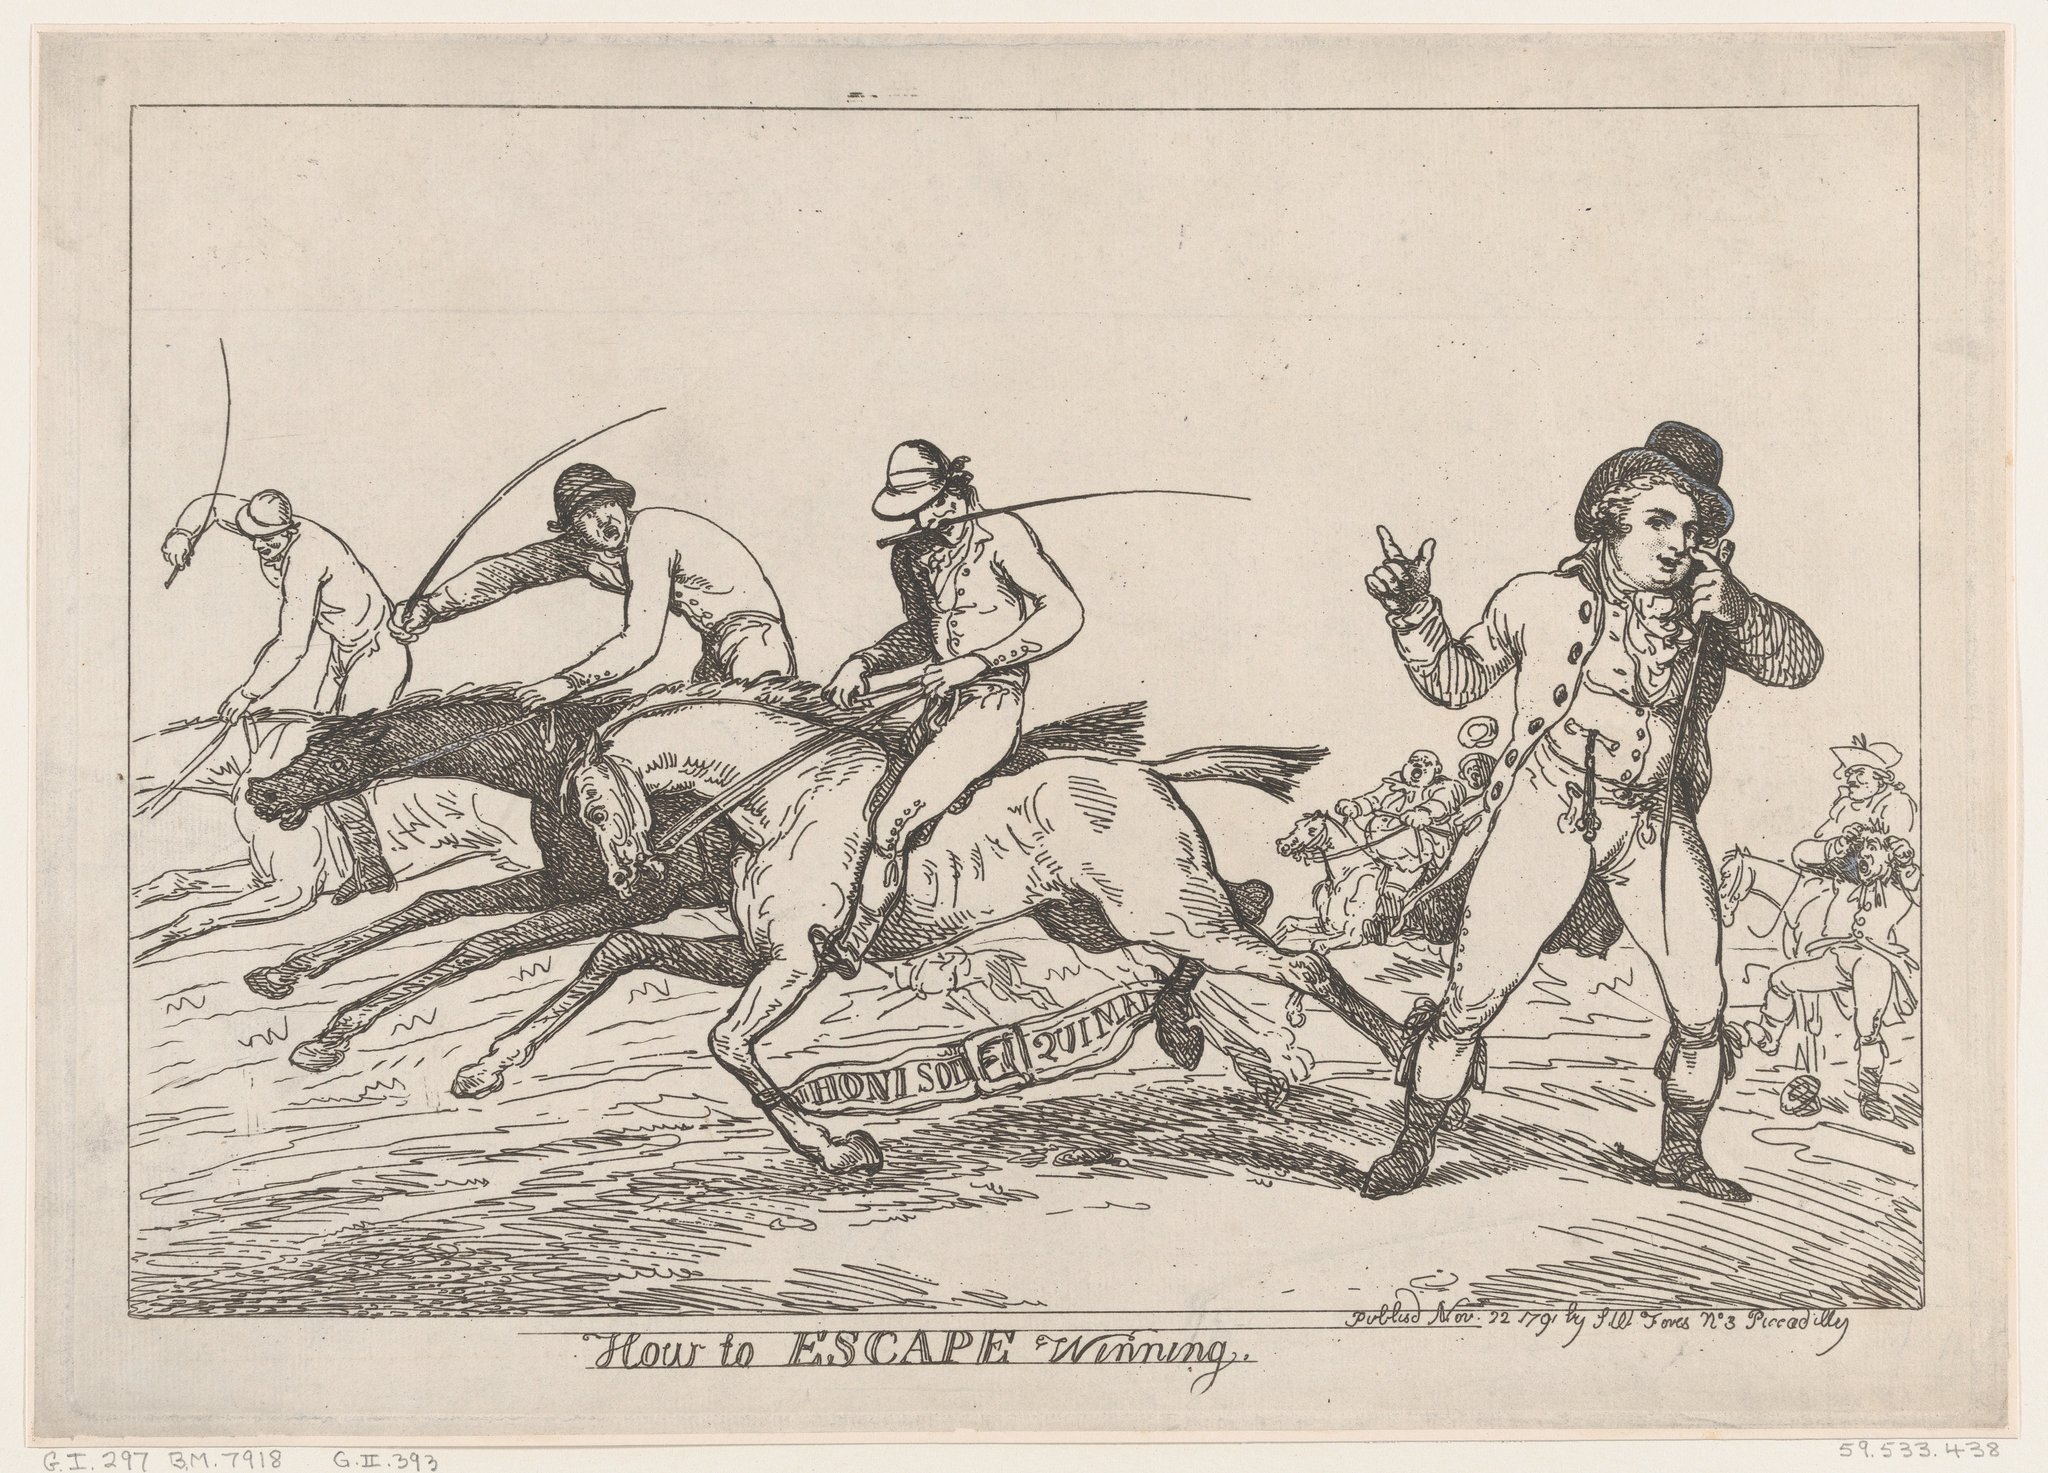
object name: print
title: How to Escape Winning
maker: thomas rowlandson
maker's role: artist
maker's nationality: british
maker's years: 1757-1827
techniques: etching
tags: men,horses,jockeys